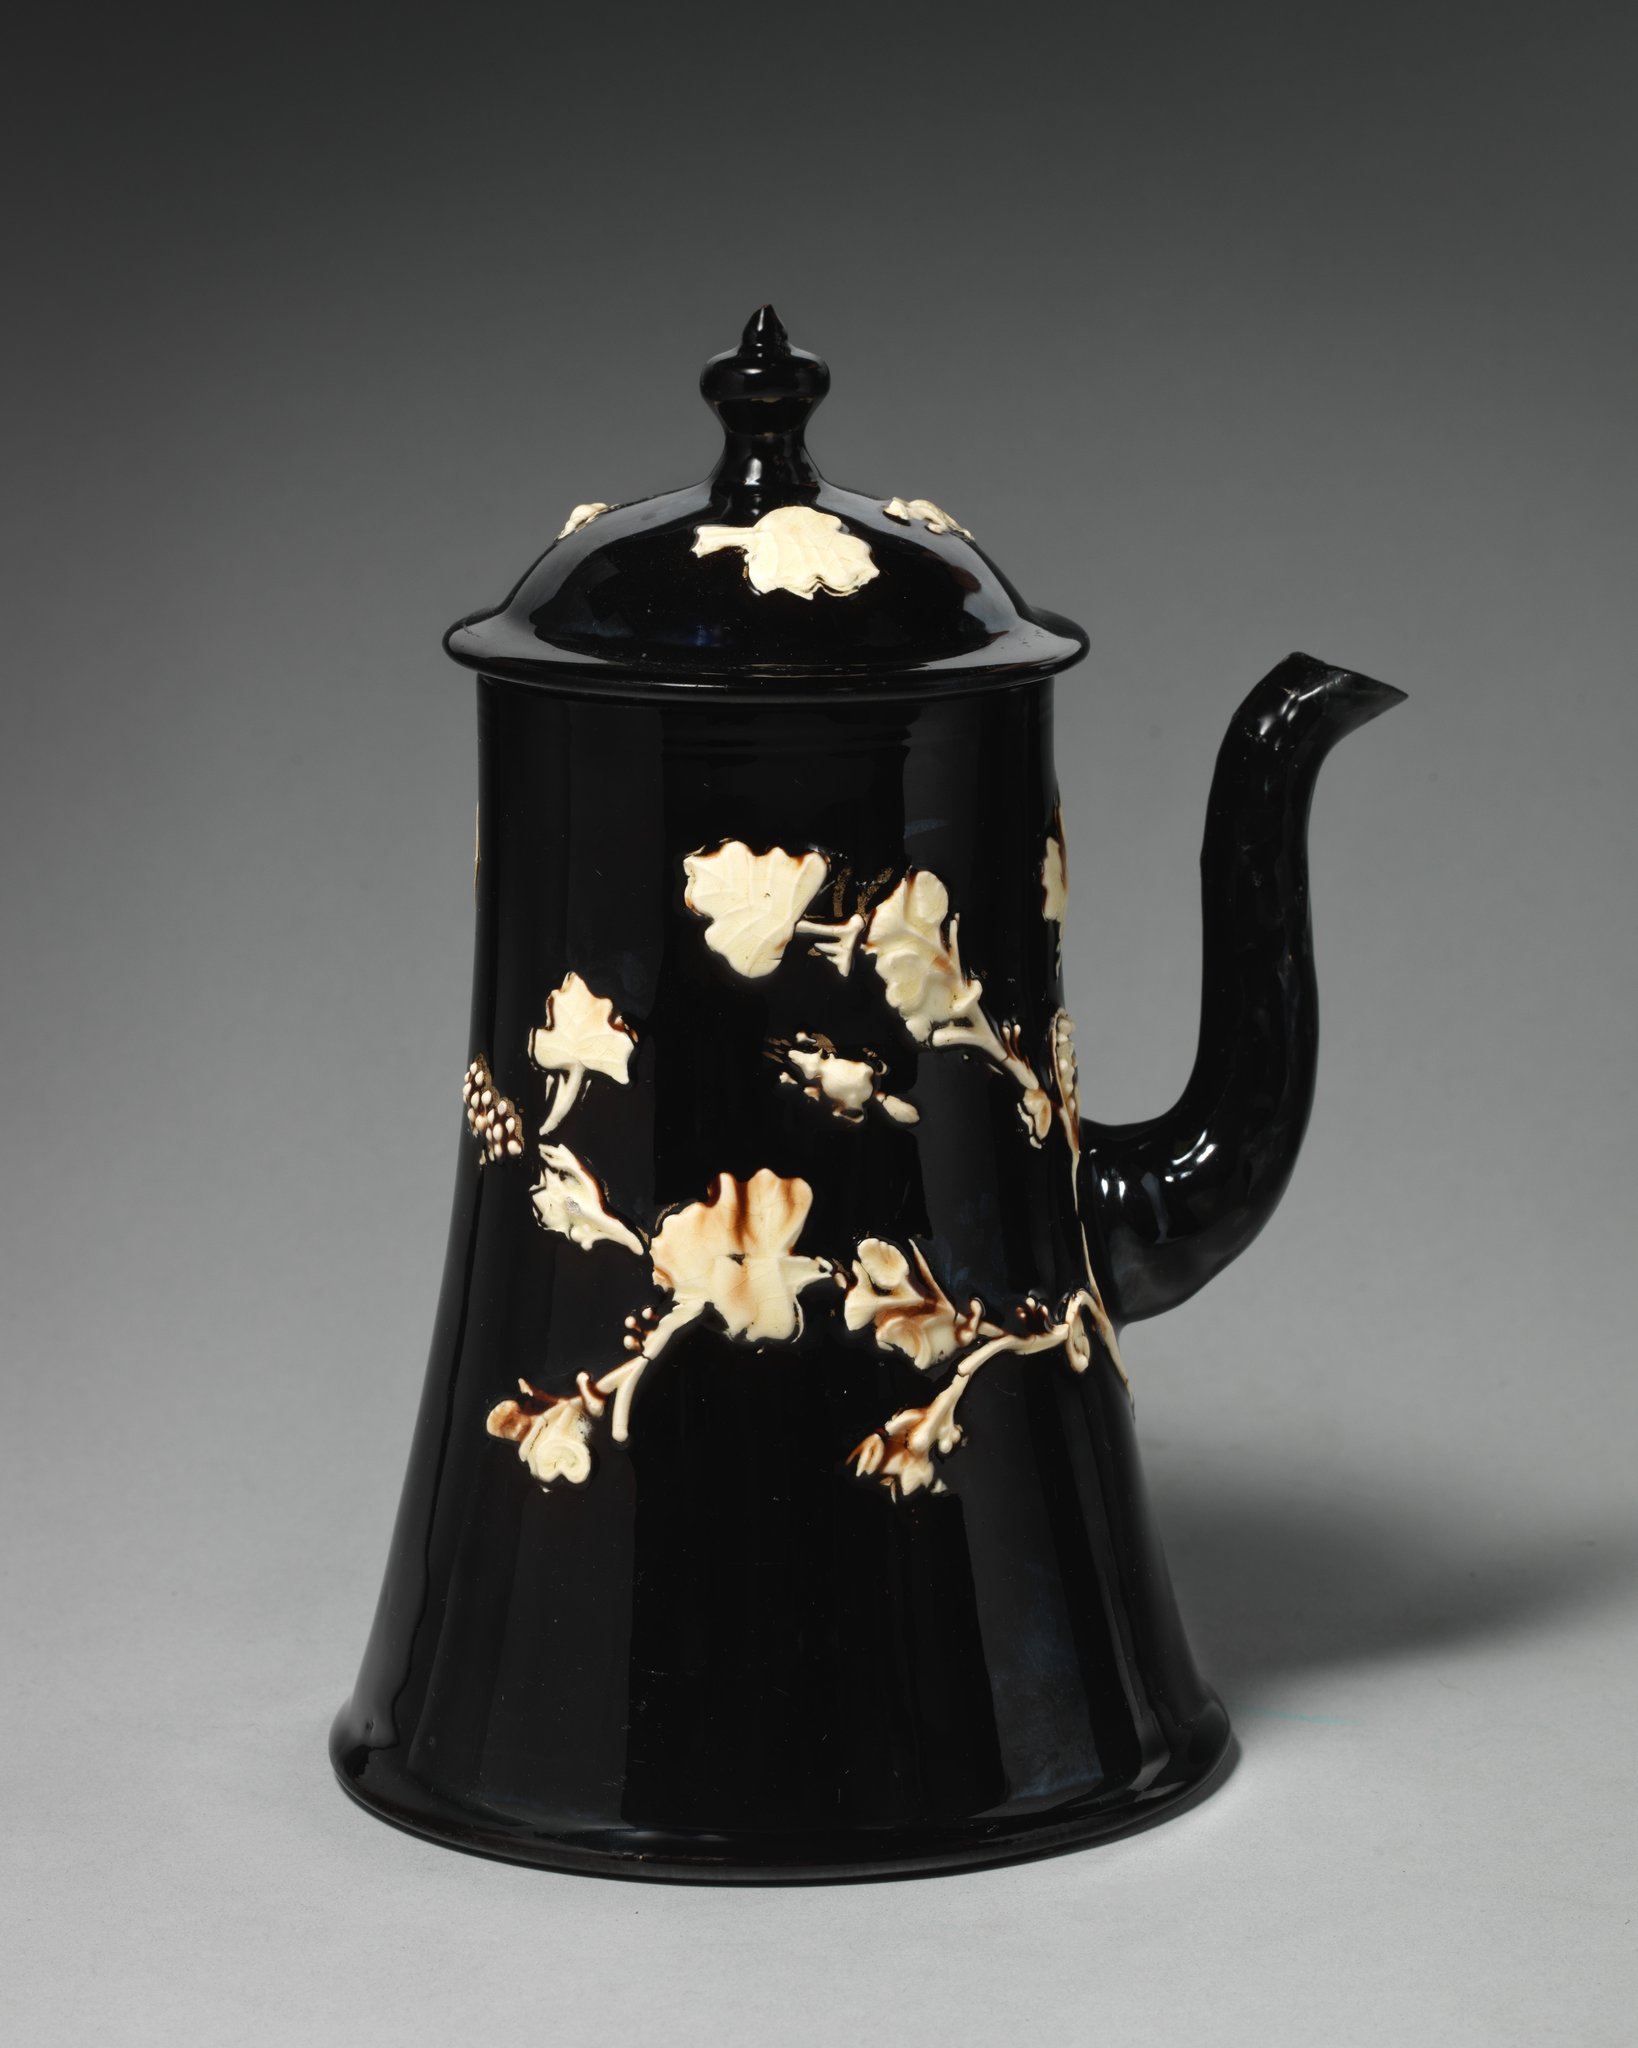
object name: coffeepot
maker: john astbury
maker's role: maker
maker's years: 1688-1743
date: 1745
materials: earthenware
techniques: glazing